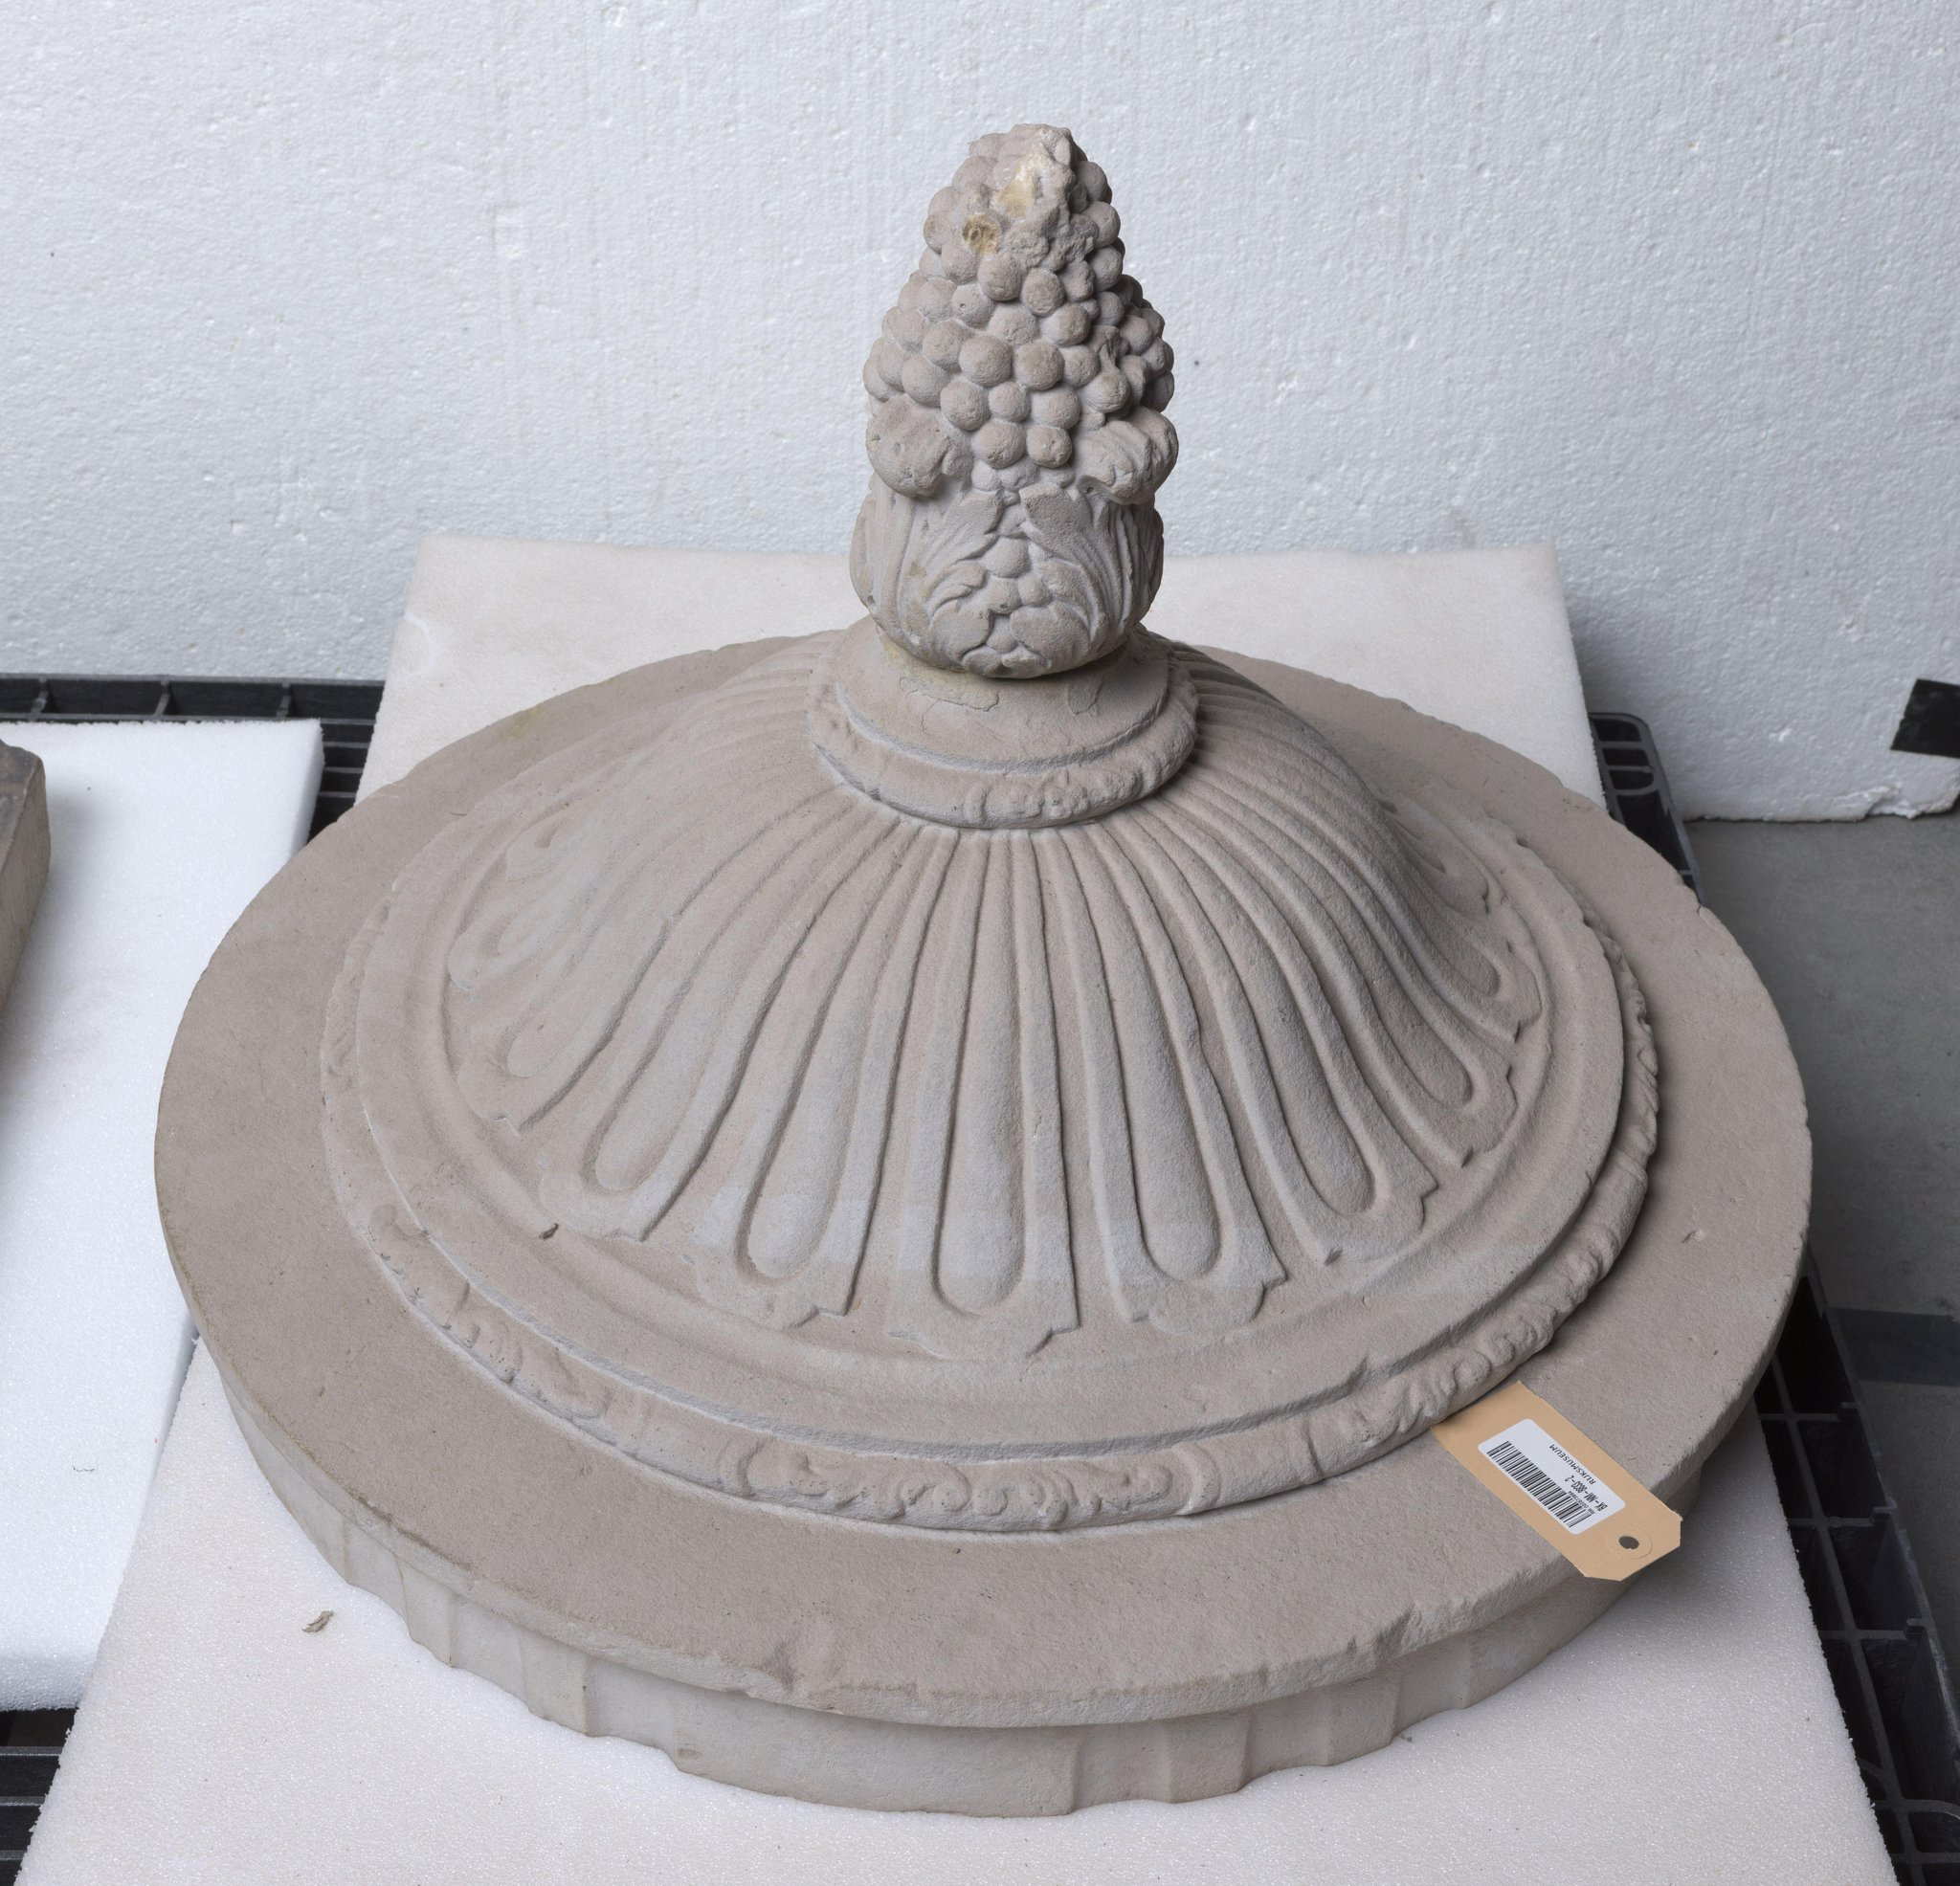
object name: lid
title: Jupiter en Callisto - Apollo en Daphne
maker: jan pieter van baurscheit (ii)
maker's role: draughtsman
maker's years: 1699-1768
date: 1700-1725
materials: stone